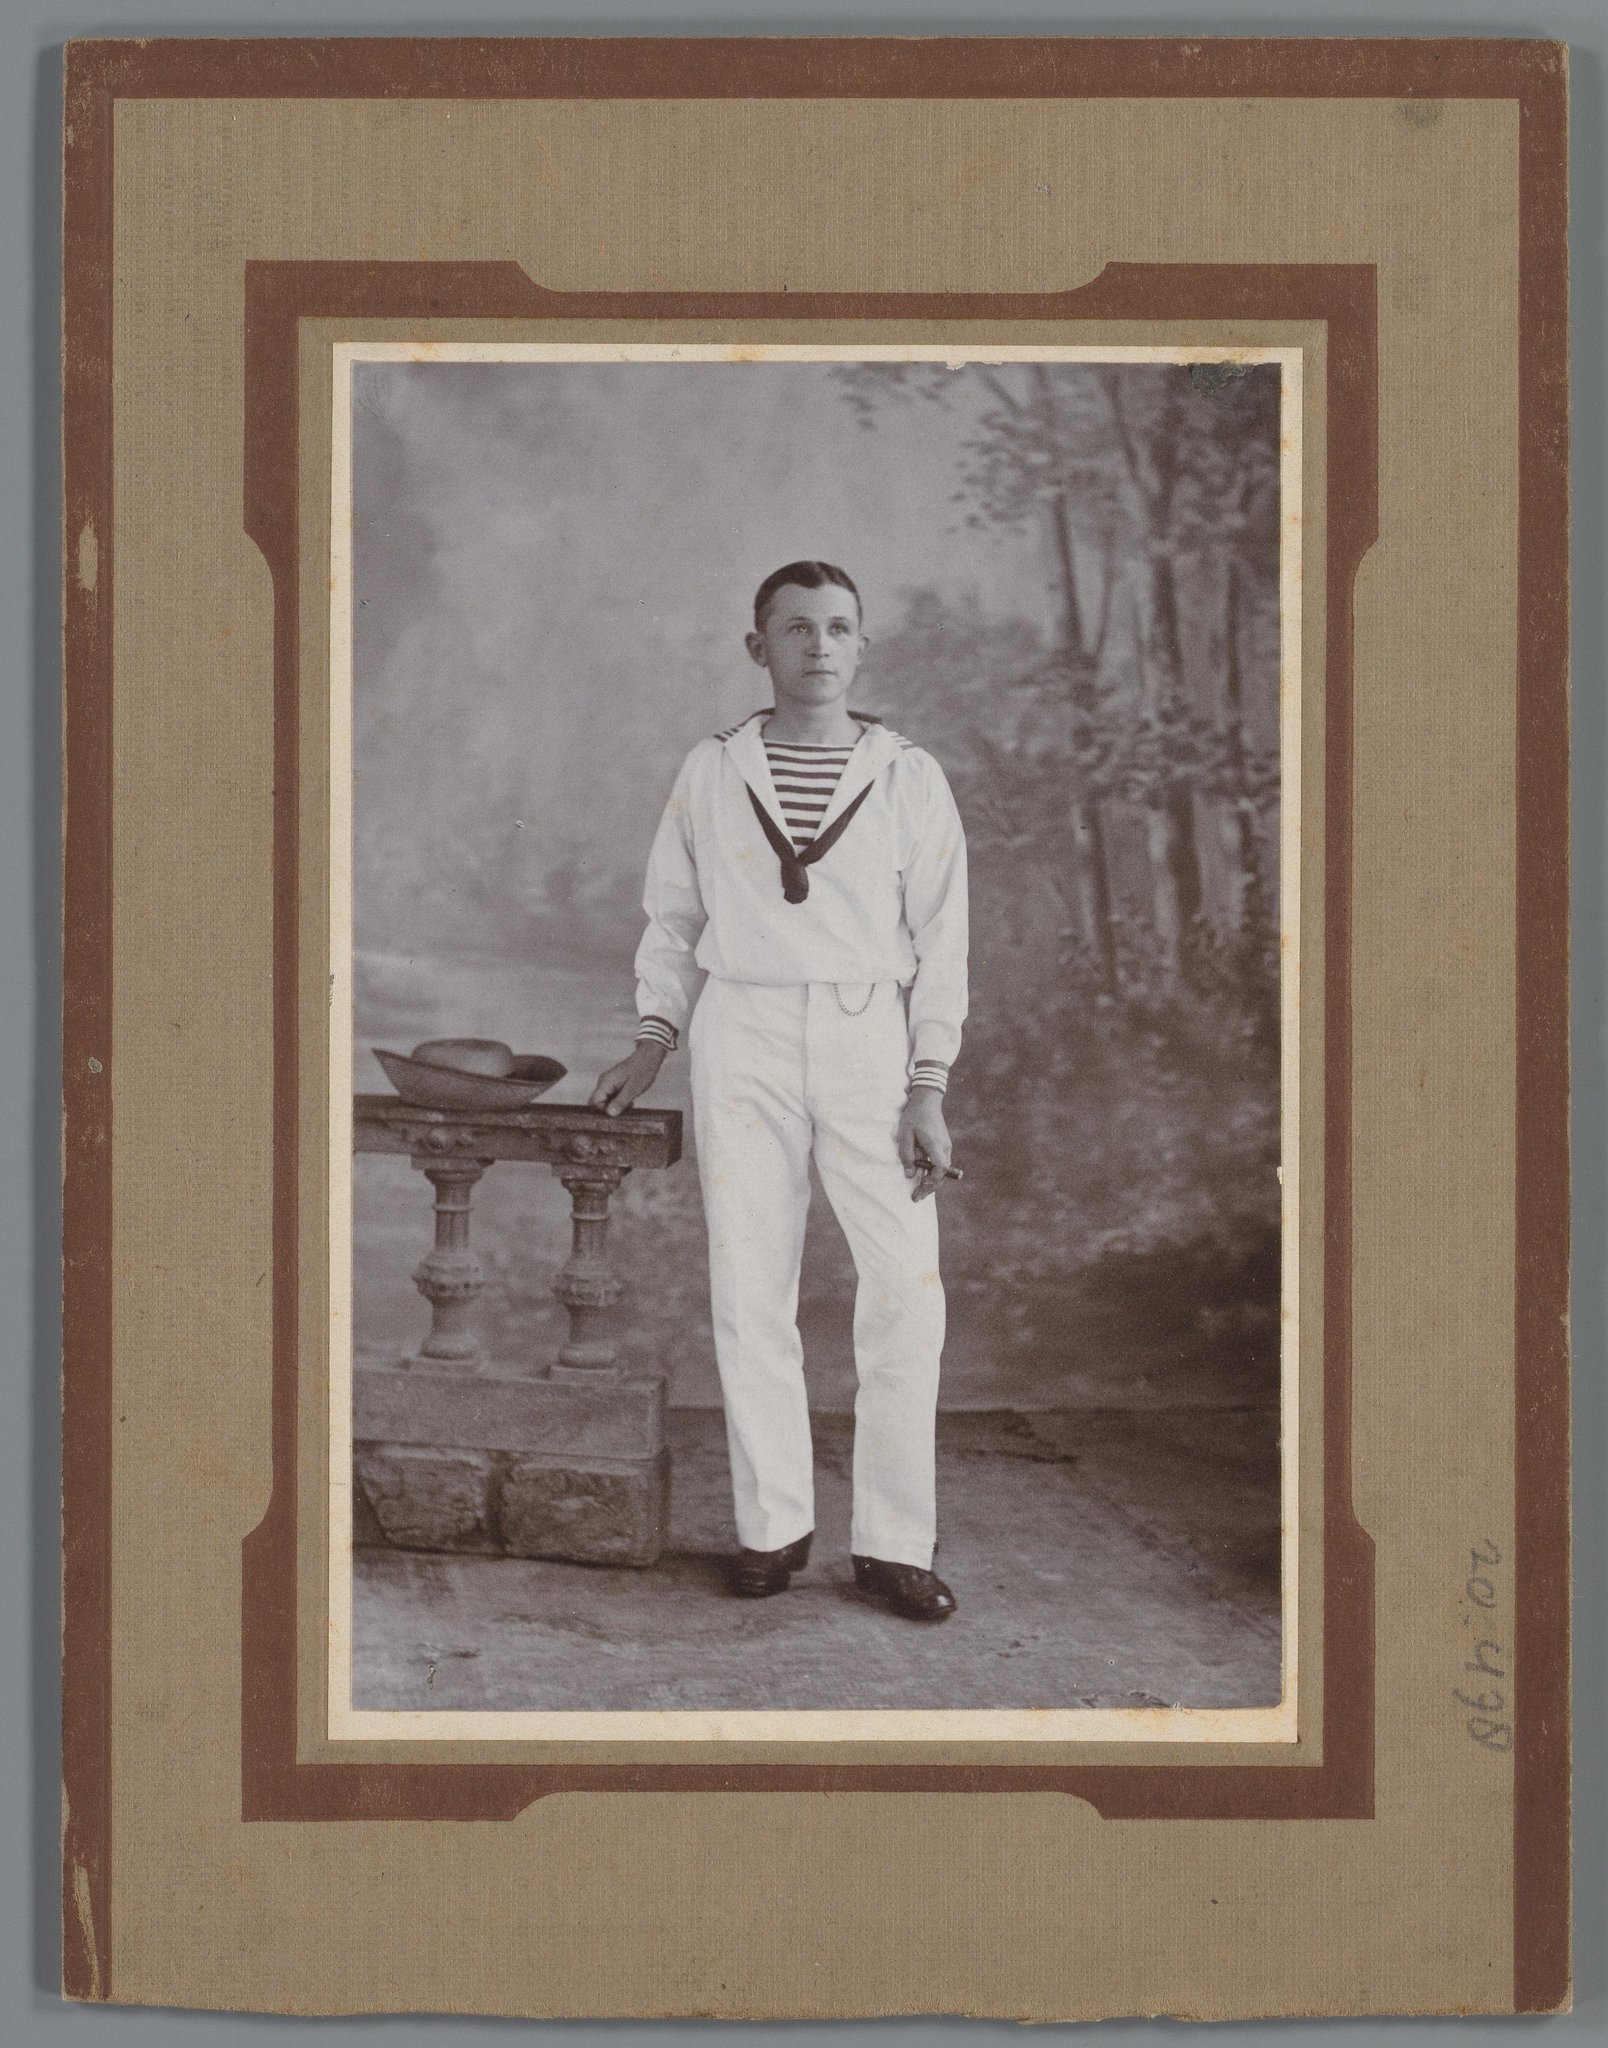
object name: photograph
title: Portret van onbekende matroos in Nederlands-Indië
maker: l.f. mellenbergh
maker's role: fotograaf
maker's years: 1868-1942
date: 1890-1920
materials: paper, cardboard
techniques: gelatin silver print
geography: malang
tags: sailor, anonymous historical person portrayed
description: De matroos die op deze foto zit is terug te zien op andere foto's; zie gerelateerde objecten.